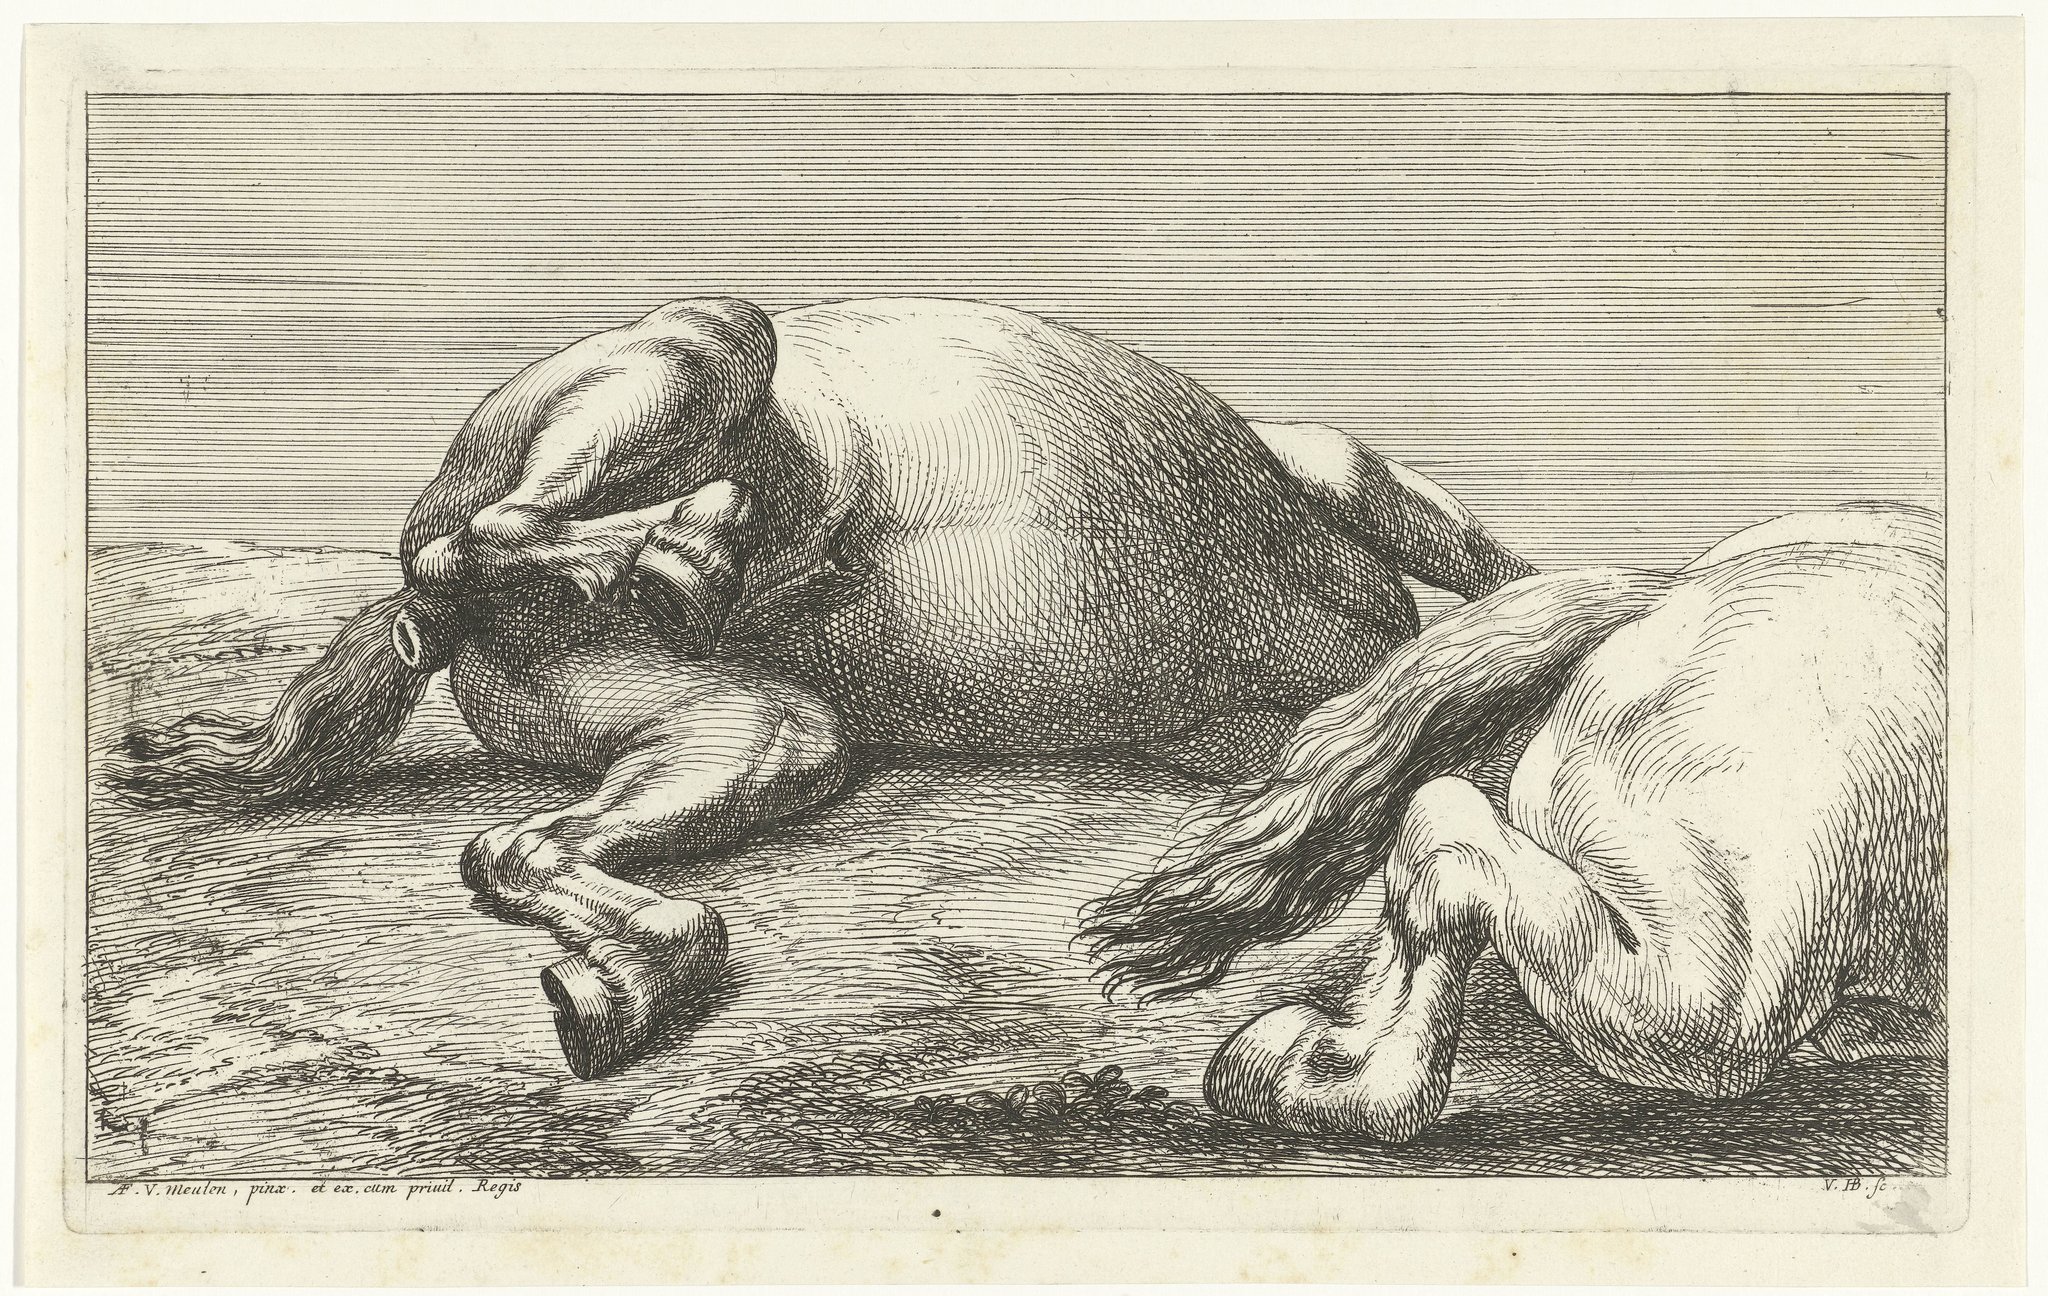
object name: print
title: Twee gesneuvelde paarden waarvan de rechter van de zijkant gezien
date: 1674-1733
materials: paper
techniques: engraving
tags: horse (+ dying animal; death of animal; dead animal)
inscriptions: collector's mark: Lugt 2228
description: In het midden een paard op de buik gezien. Rechts de achterkant van een paard van de zijkant gezien.